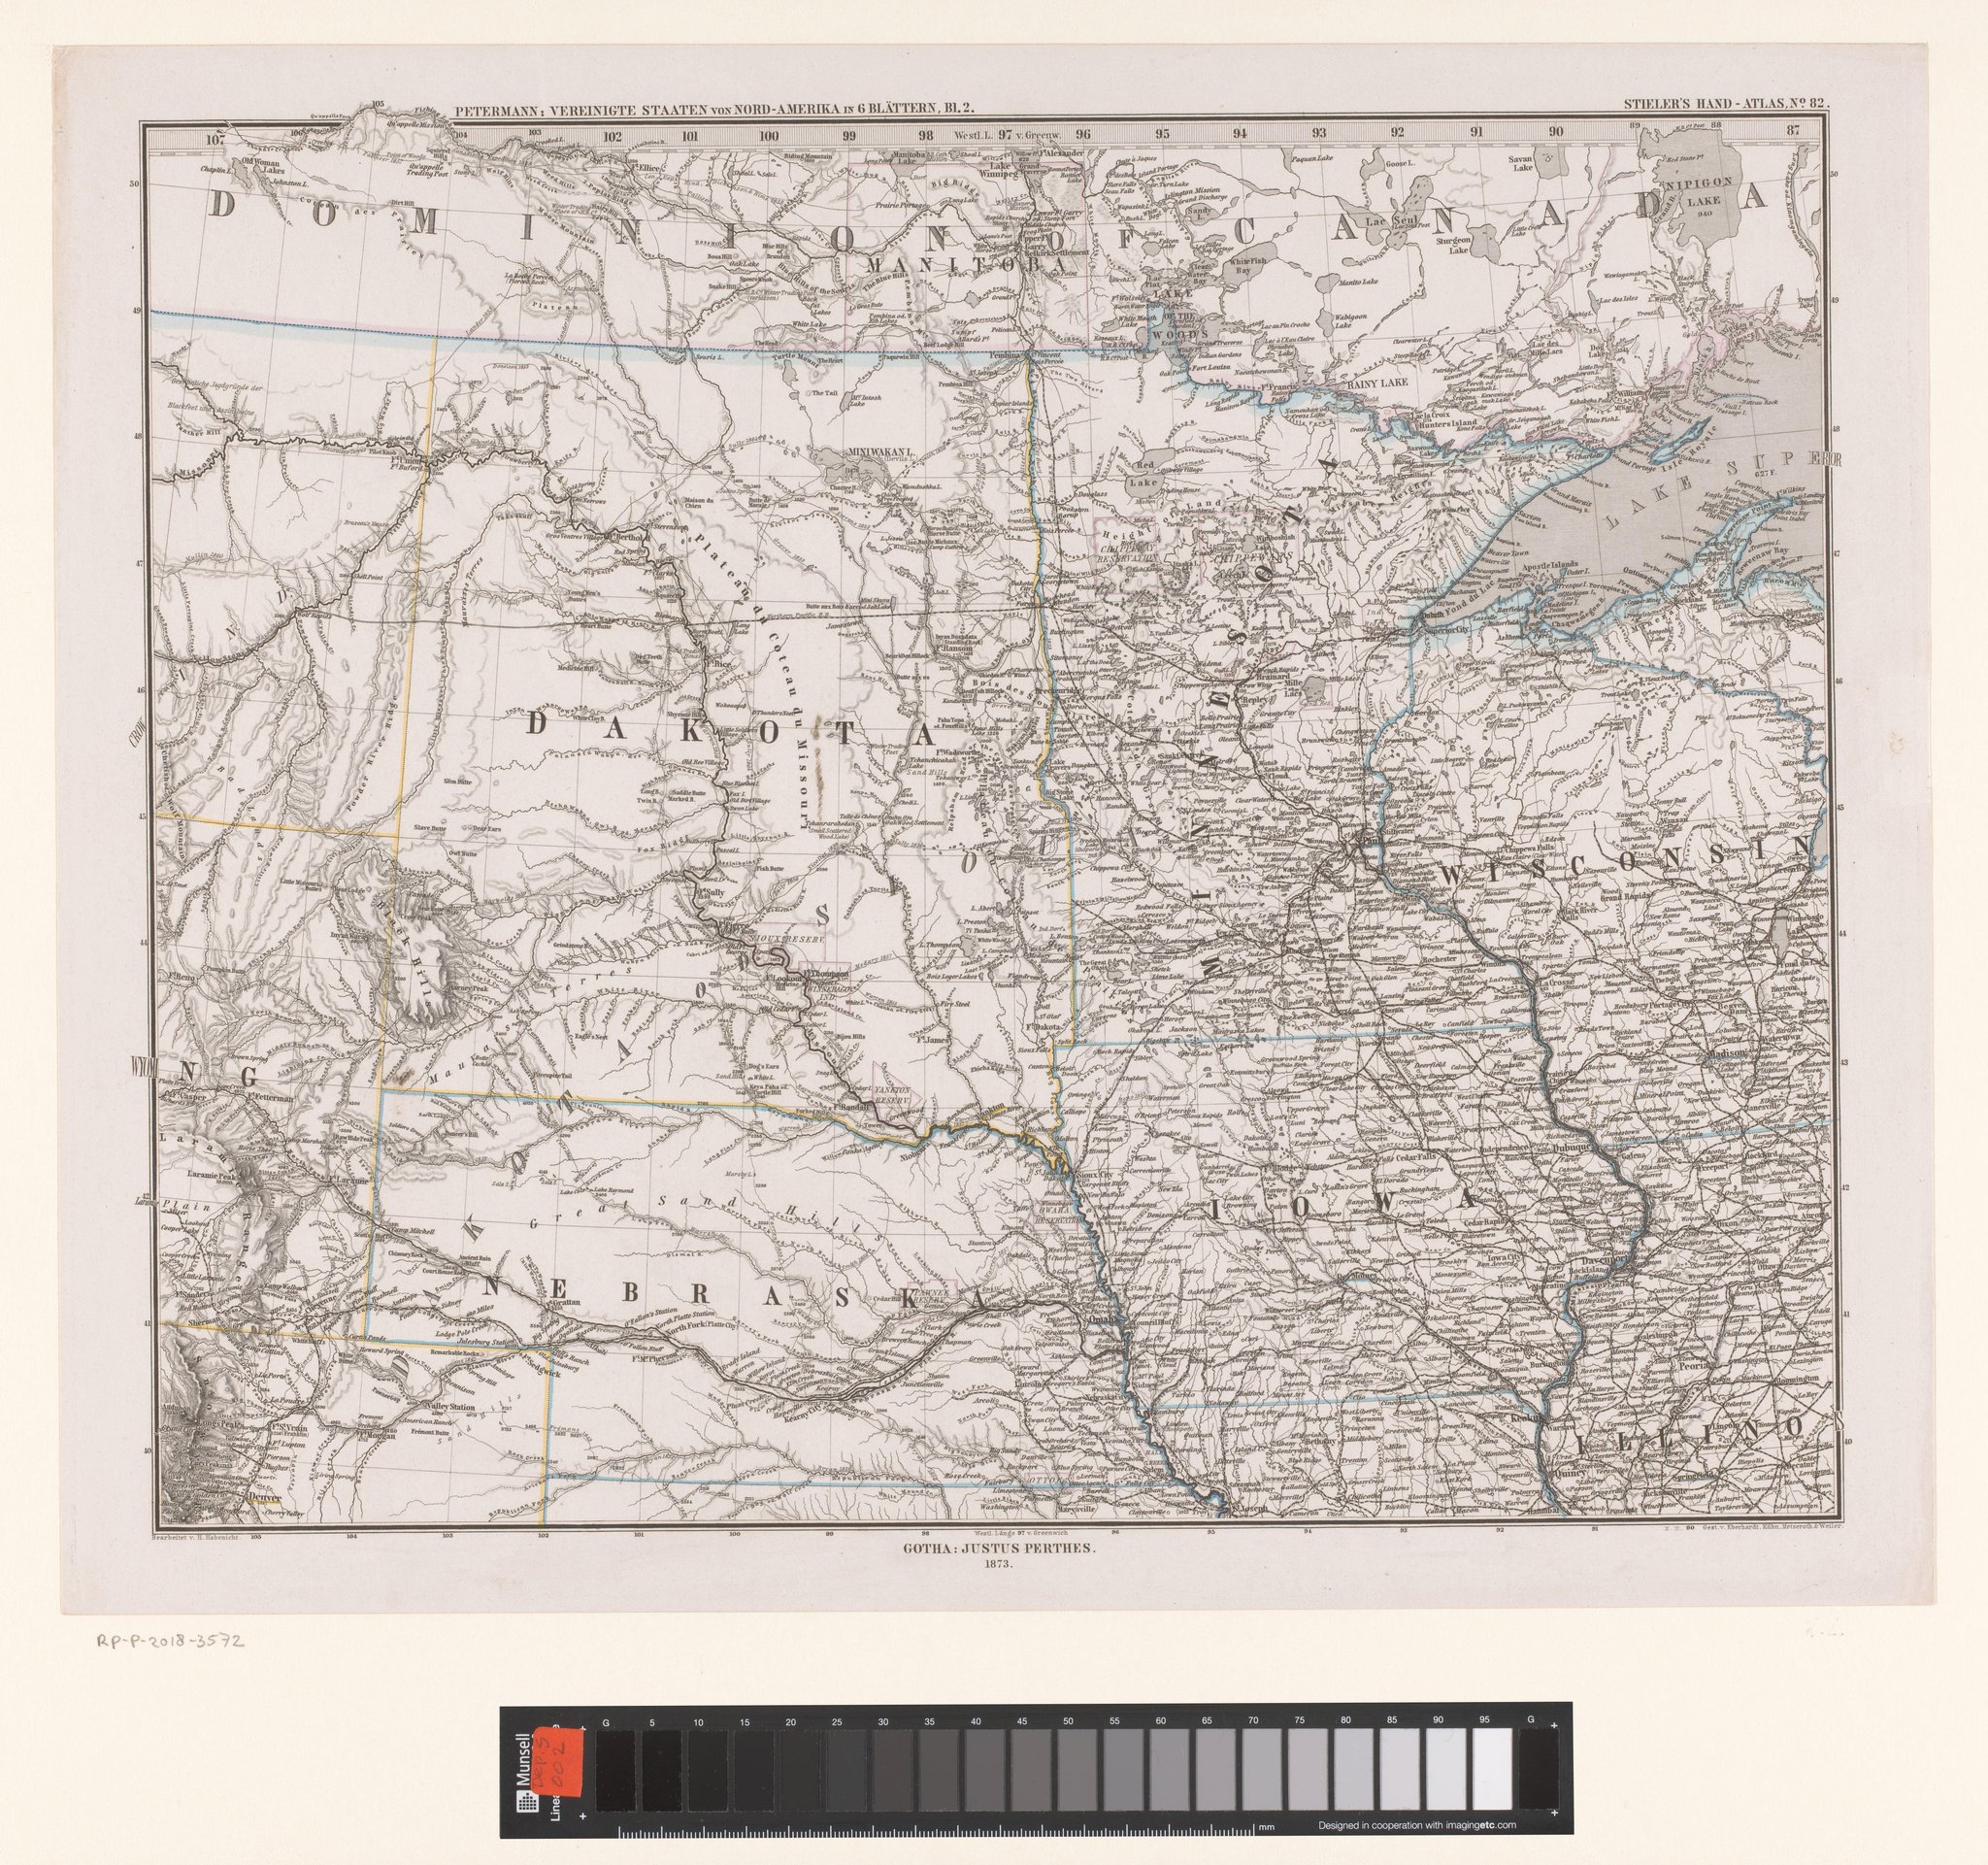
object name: print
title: Vereinigte Staaten von Nord-Amerika in 6 Blättern, Bl. 2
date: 1873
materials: paper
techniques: hand coloring, lithograph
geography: gotha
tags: maps, atlases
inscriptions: date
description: Kaart van een gedeelte van de Verenigde Staten in Noord-Amerika. Onder andere: Dakota, Nebraska, Iowa, Wisconsin en Minnesota. Rechtsboven: "Stieler's Hand-Atlas N82".